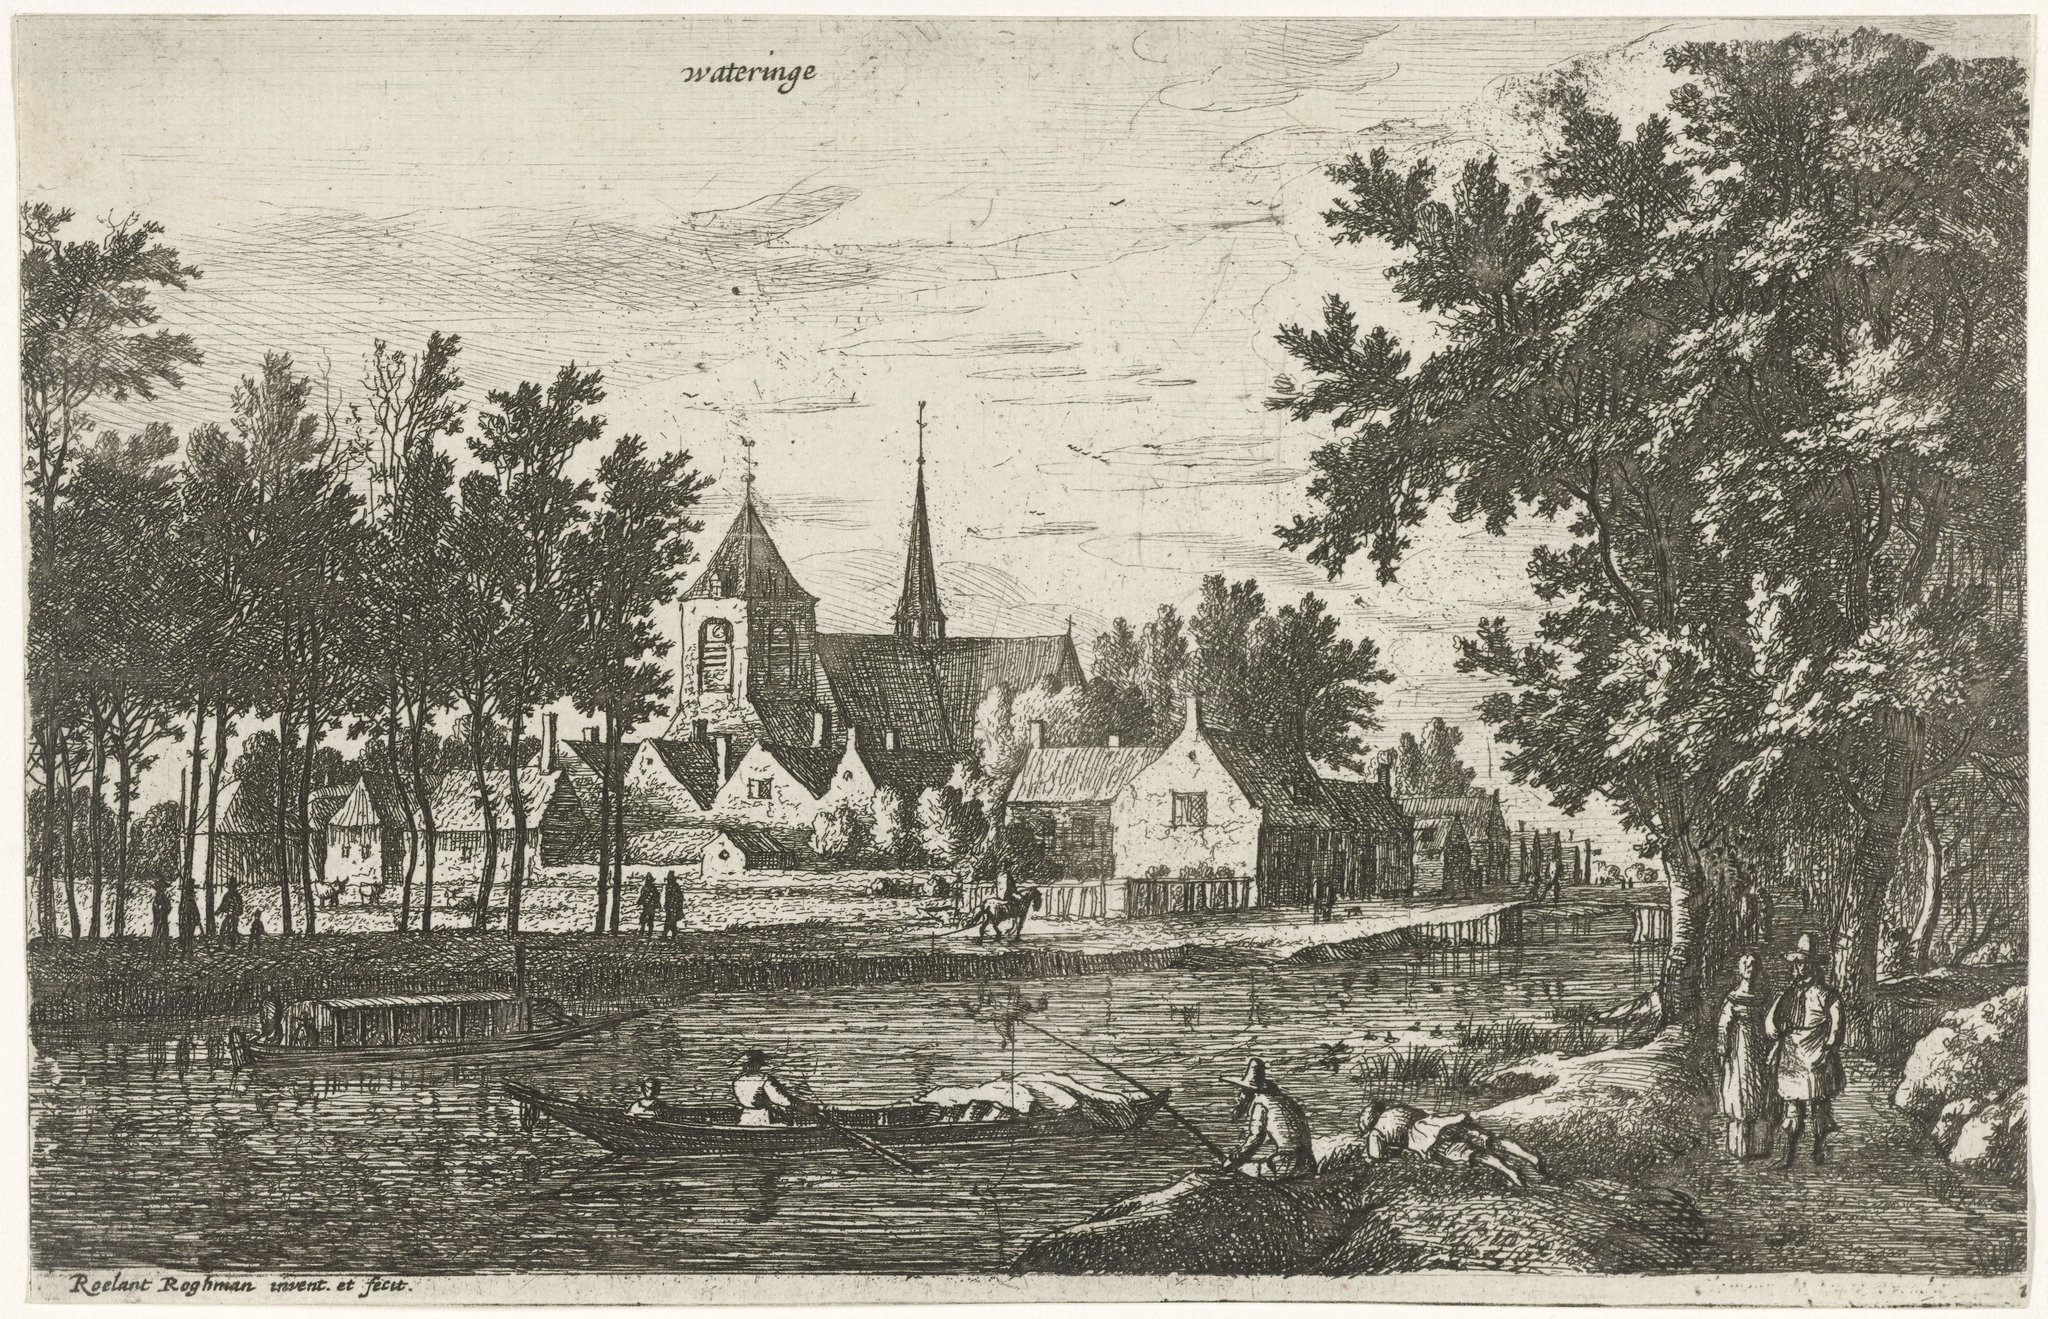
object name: print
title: Gezicht op Wateringen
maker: roelant roghman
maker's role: draughtsman, painter, print maker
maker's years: 1627-1692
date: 1643-1677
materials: paper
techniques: etching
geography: amsterdam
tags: prospect of village, silhouette of village, river, church (exterior), rowing-boat, canoe, etc., fisherman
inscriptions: collector's mark: Lugt 2228a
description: Gezicht vanaf het water op het dorp Wateringen en een kerk. Rechts een bospad met enkele passanten en een visser aan de waterkant. Op het water twee boten en op de achtergrond een brug. Rechtsonder genummerd: 1.